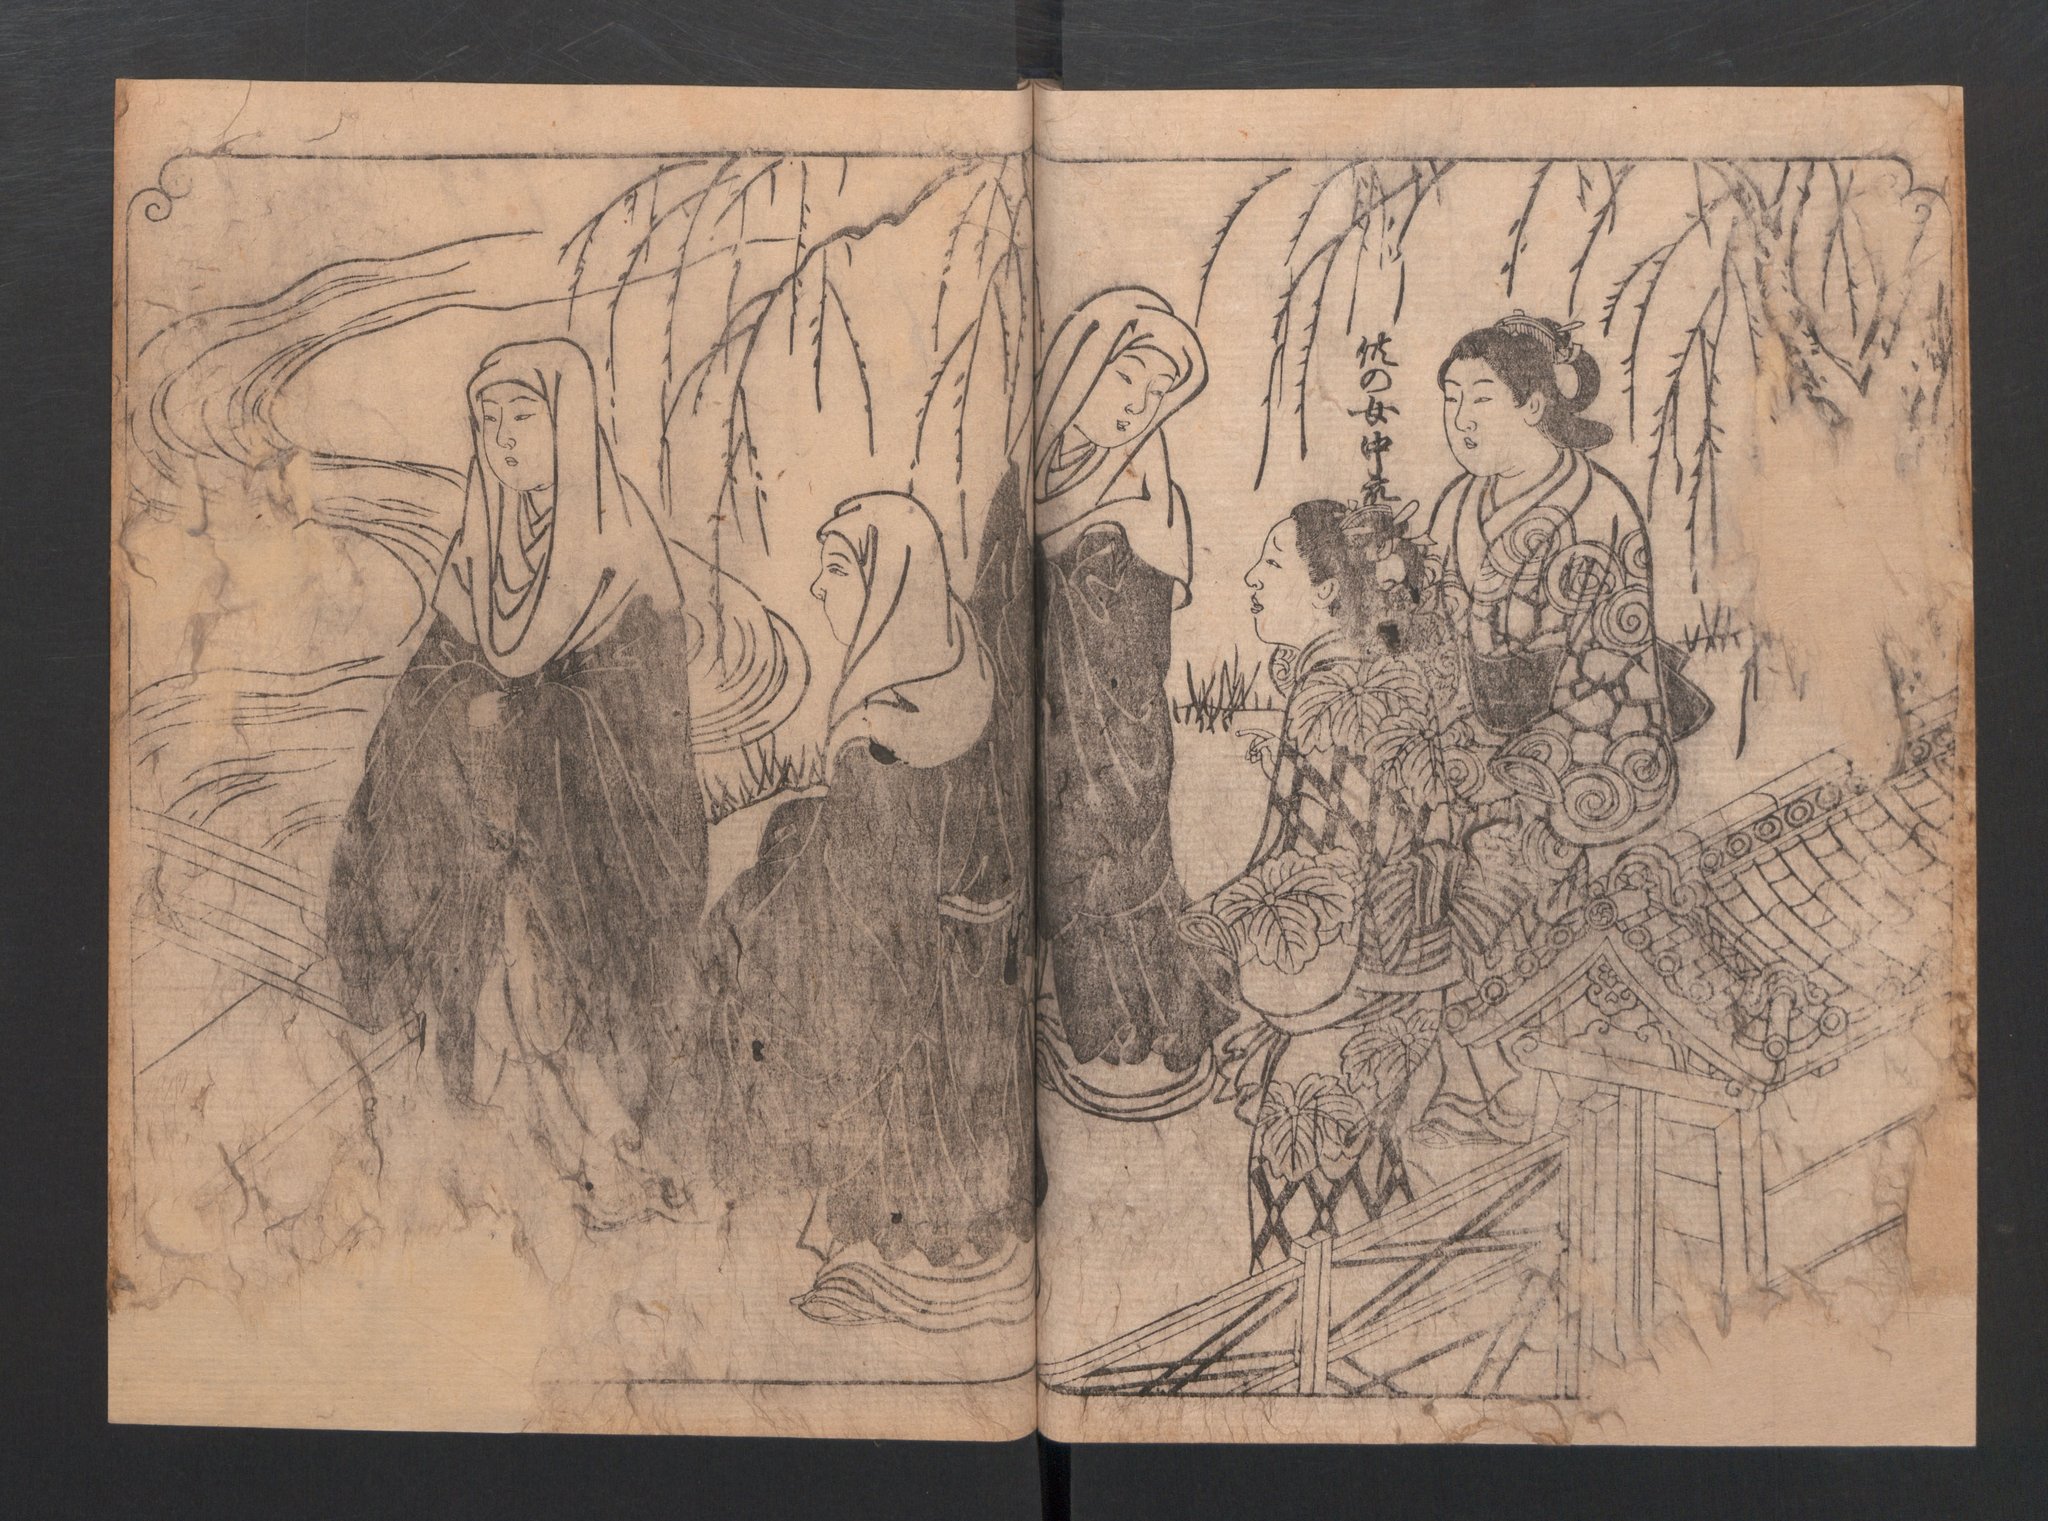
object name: illustrated book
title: One Hundred Women Classified According to Their Rank (Hyakunin joro shinasadame) 百人女郎品定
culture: japanese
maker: nishikawa sukenobu 西川祐信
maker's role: artist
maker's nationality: japanese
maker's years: 1671-1750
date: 1723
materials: ink, paper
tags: women